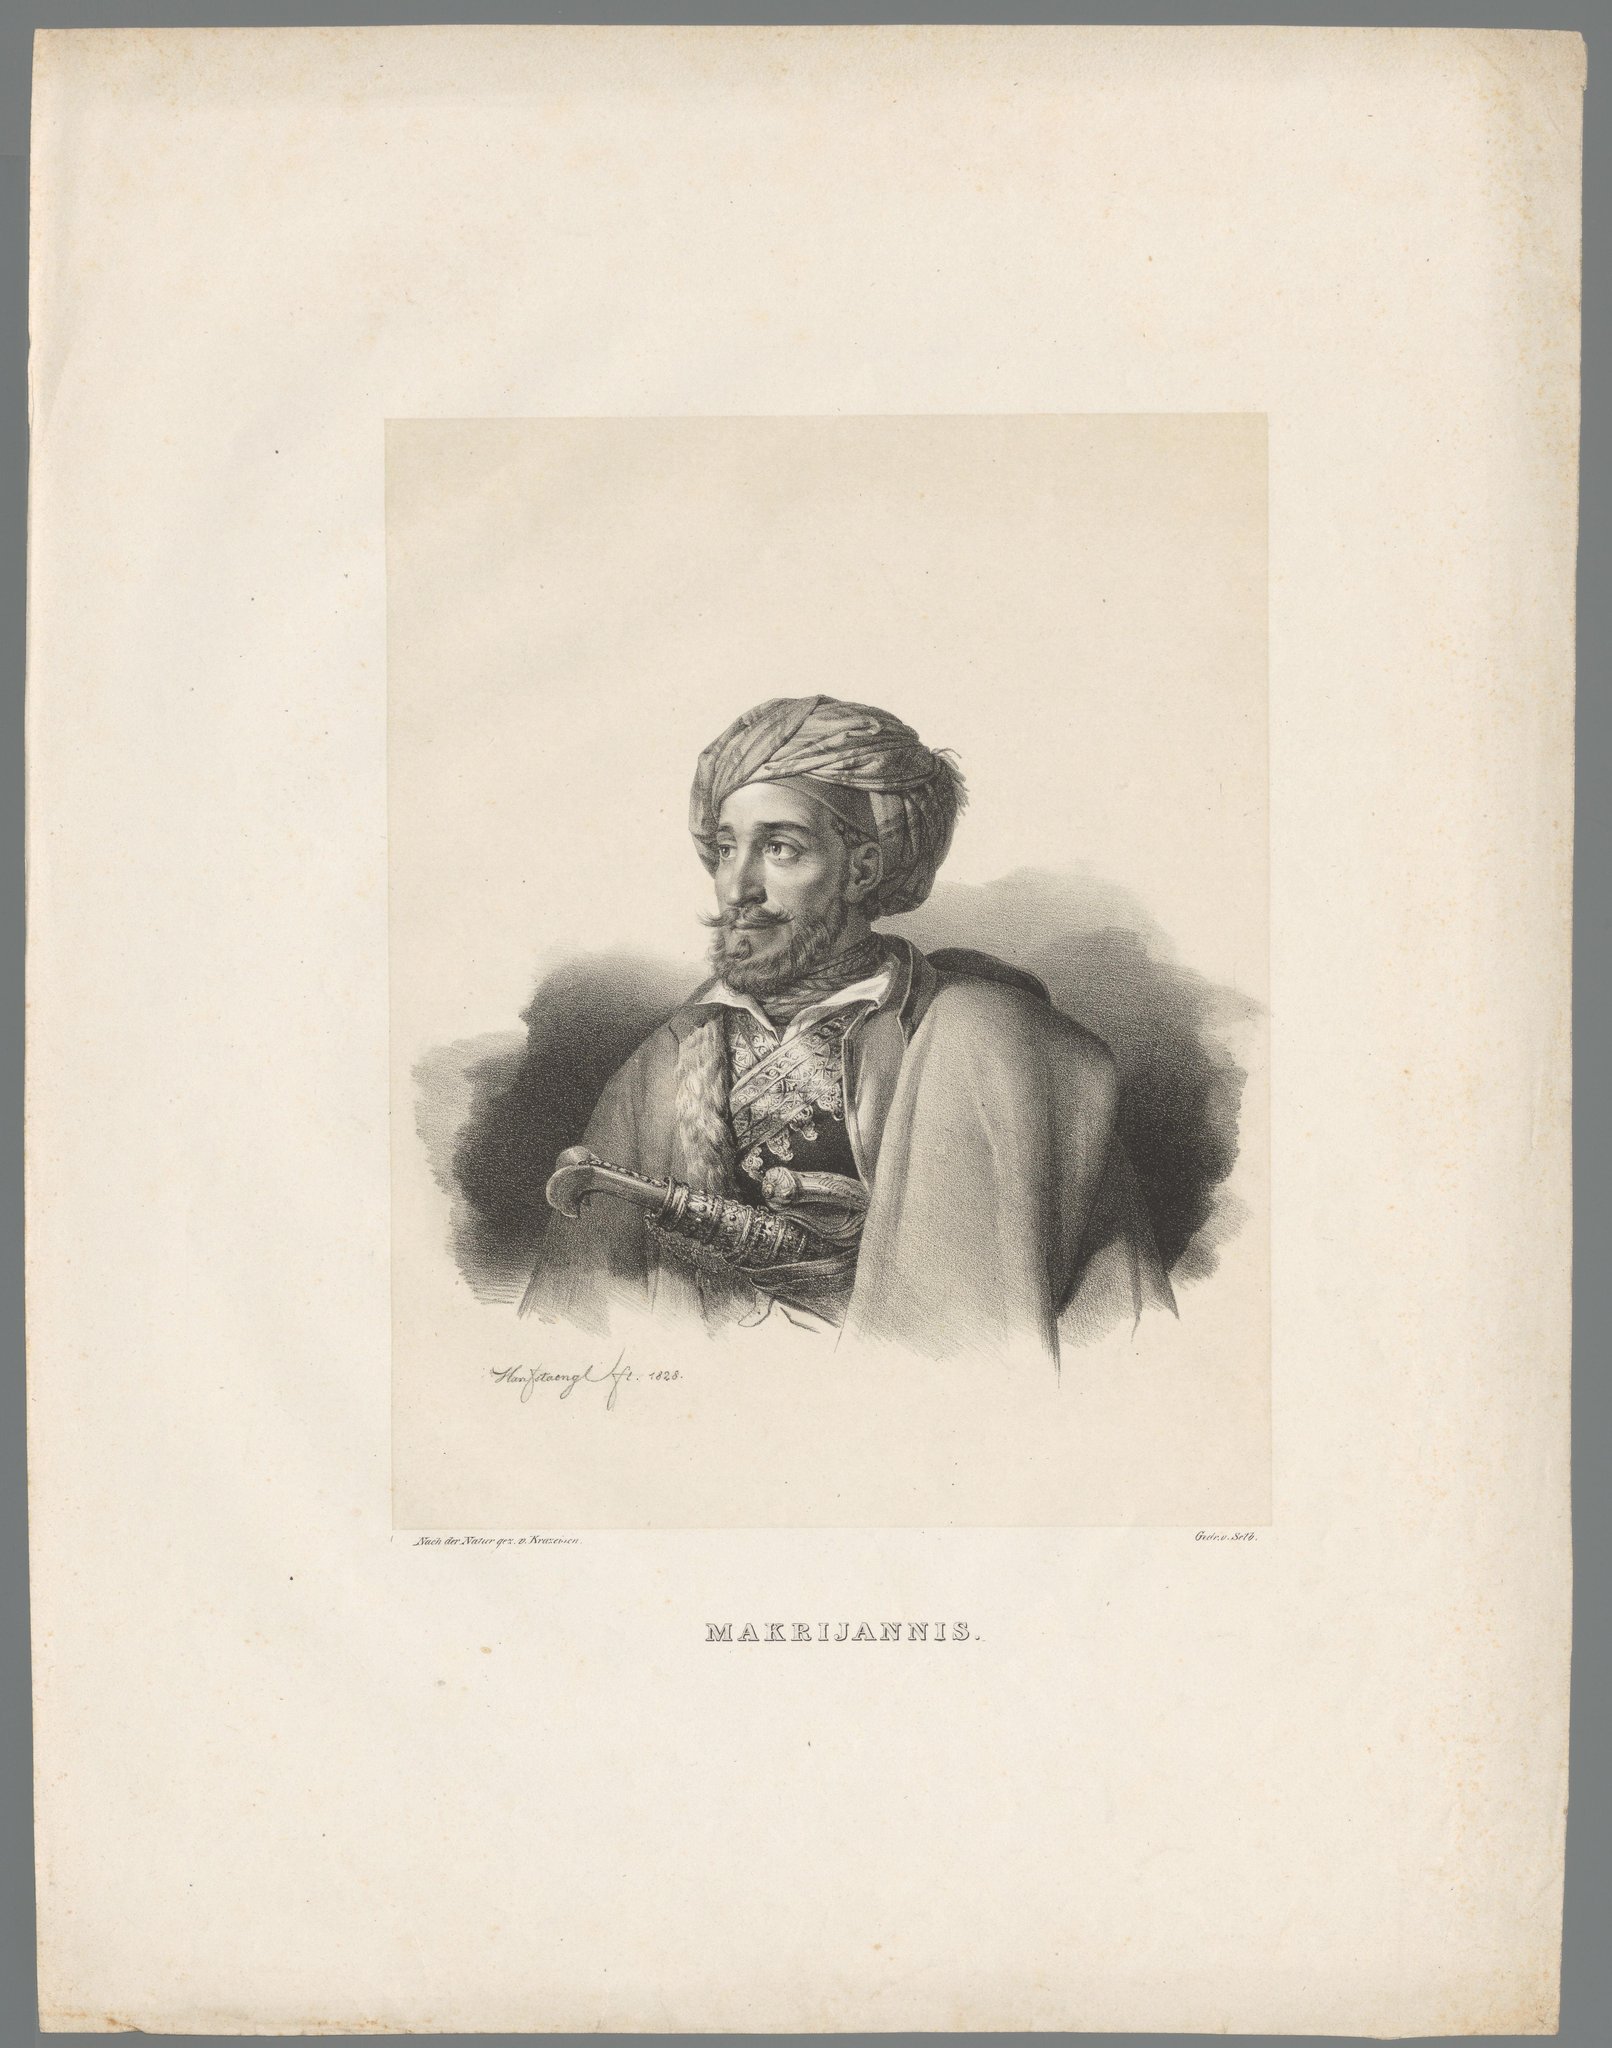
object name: print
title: Portret van Yannis Makriyannis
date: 1828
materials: paper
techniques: tone lithography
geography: munich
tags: adult man, historical persons, beard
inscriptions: collector's mark: Lugt 2228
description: De prent hoort mogelijk bij een serie prenten met portretten van betrokkenen bij de Griekse onafhankelijkheidsoorlog. Mogelijk de serie: Bildnisse ausgezeichneter Greichen und Philhellene nebst einigen Ansichten und Trachten.